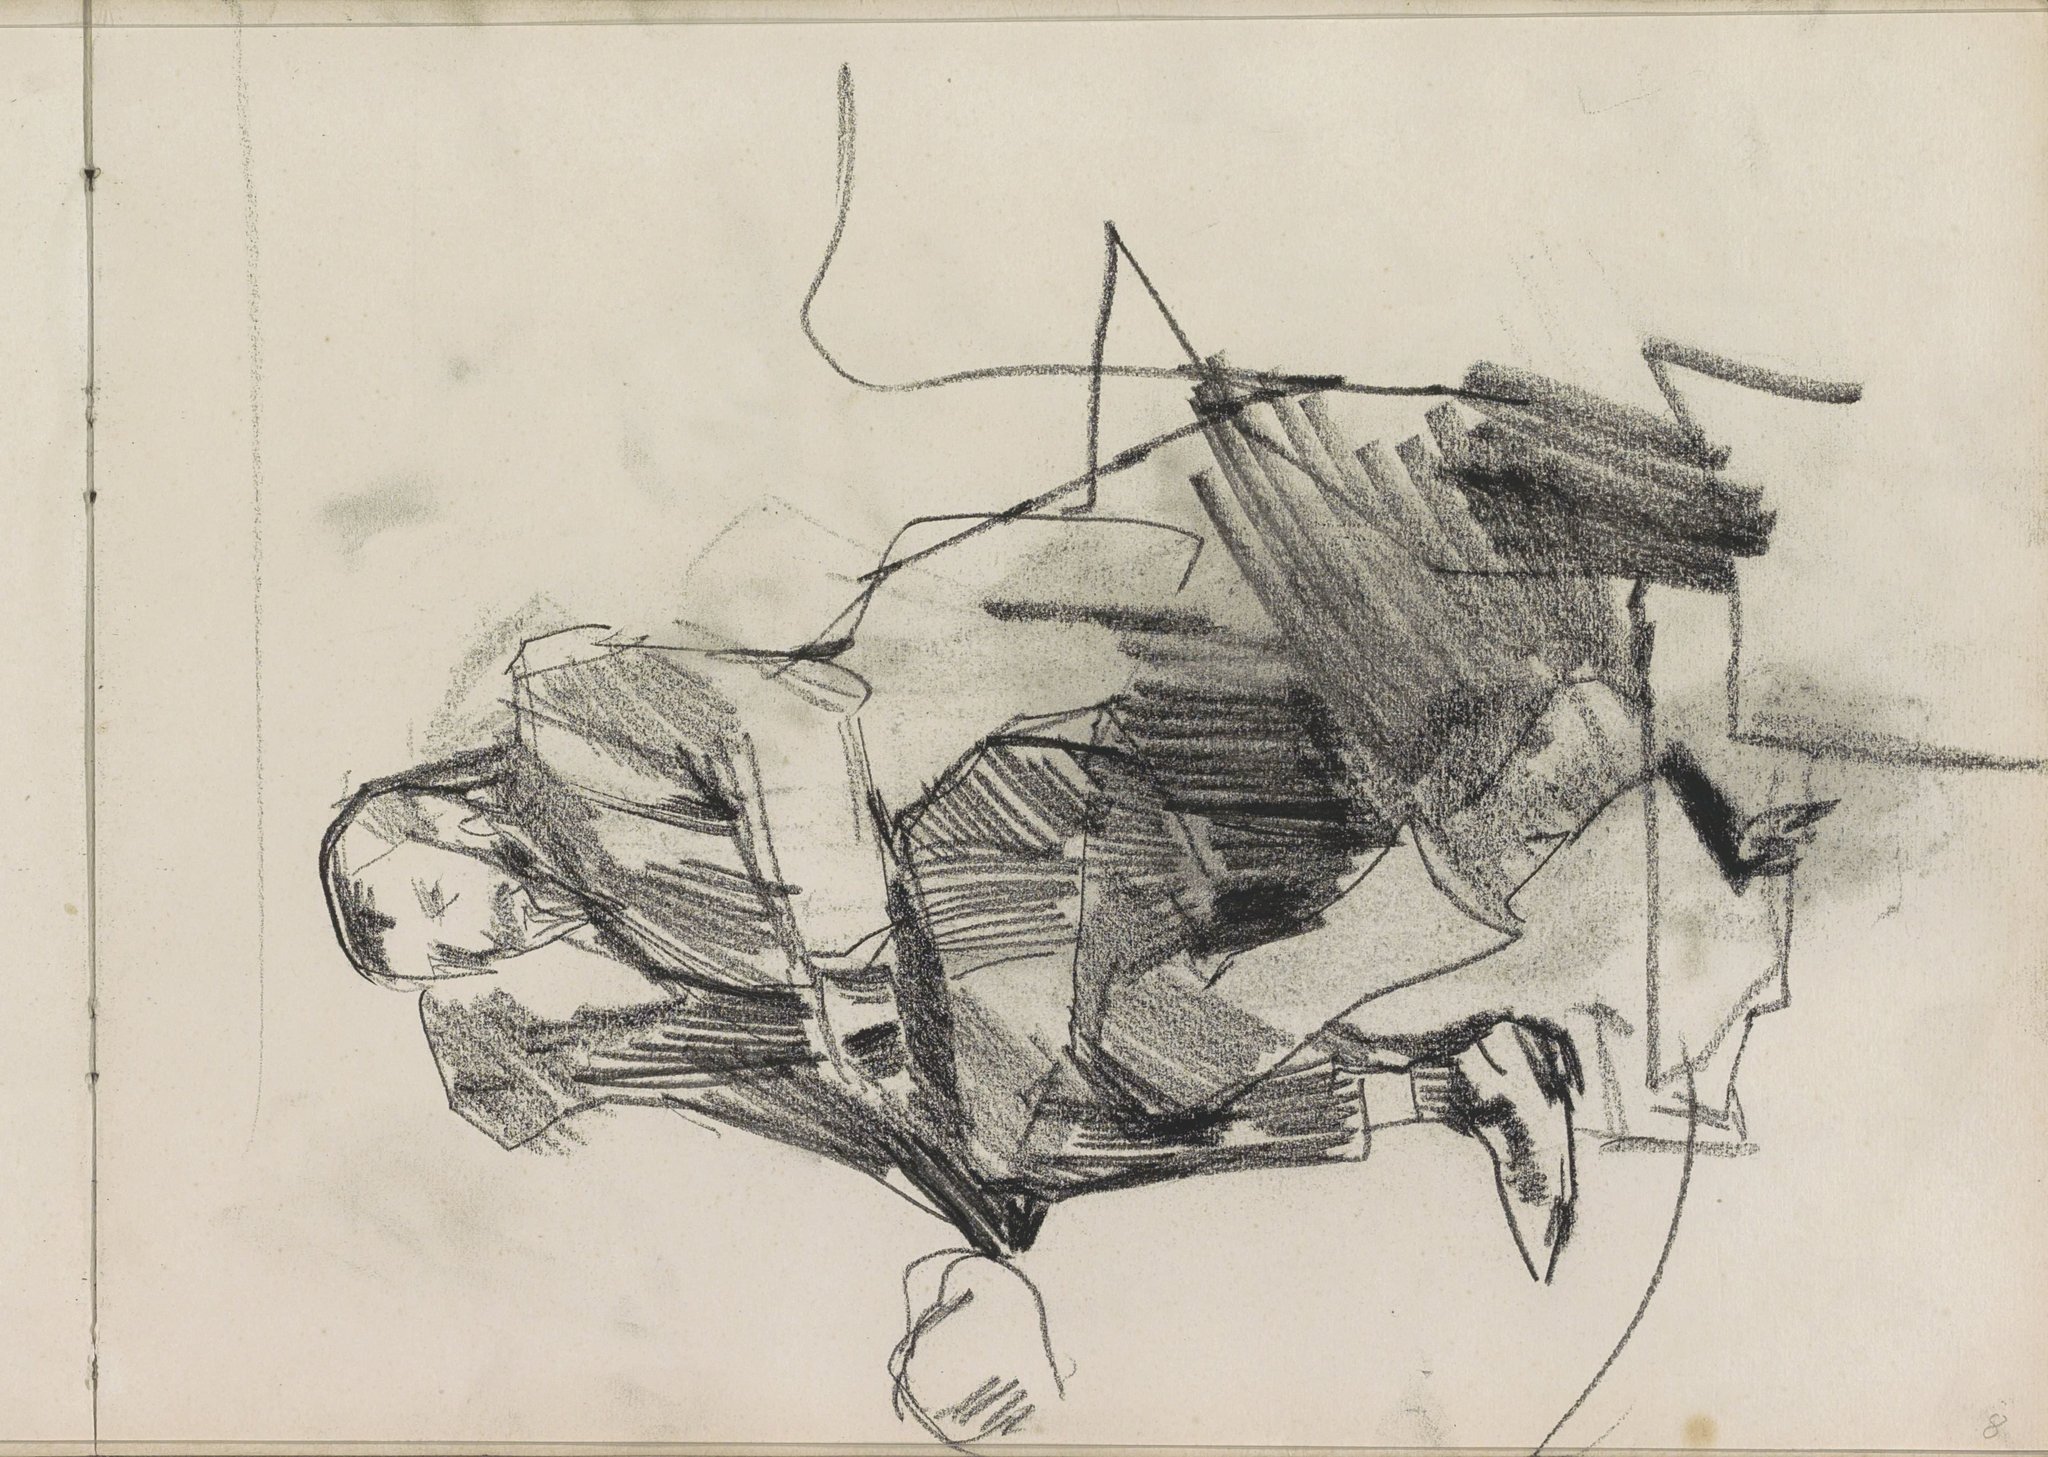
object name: sketchbook leaf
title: Zittende man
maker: isaac israels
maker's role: draughtsman, painter, print maker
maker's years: 1865-1934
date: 1892-1900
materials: chalk, paper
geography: the hague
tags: sitting on an elevation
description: Blad 8 recto uit schetsboek VIII met 12 bladen.